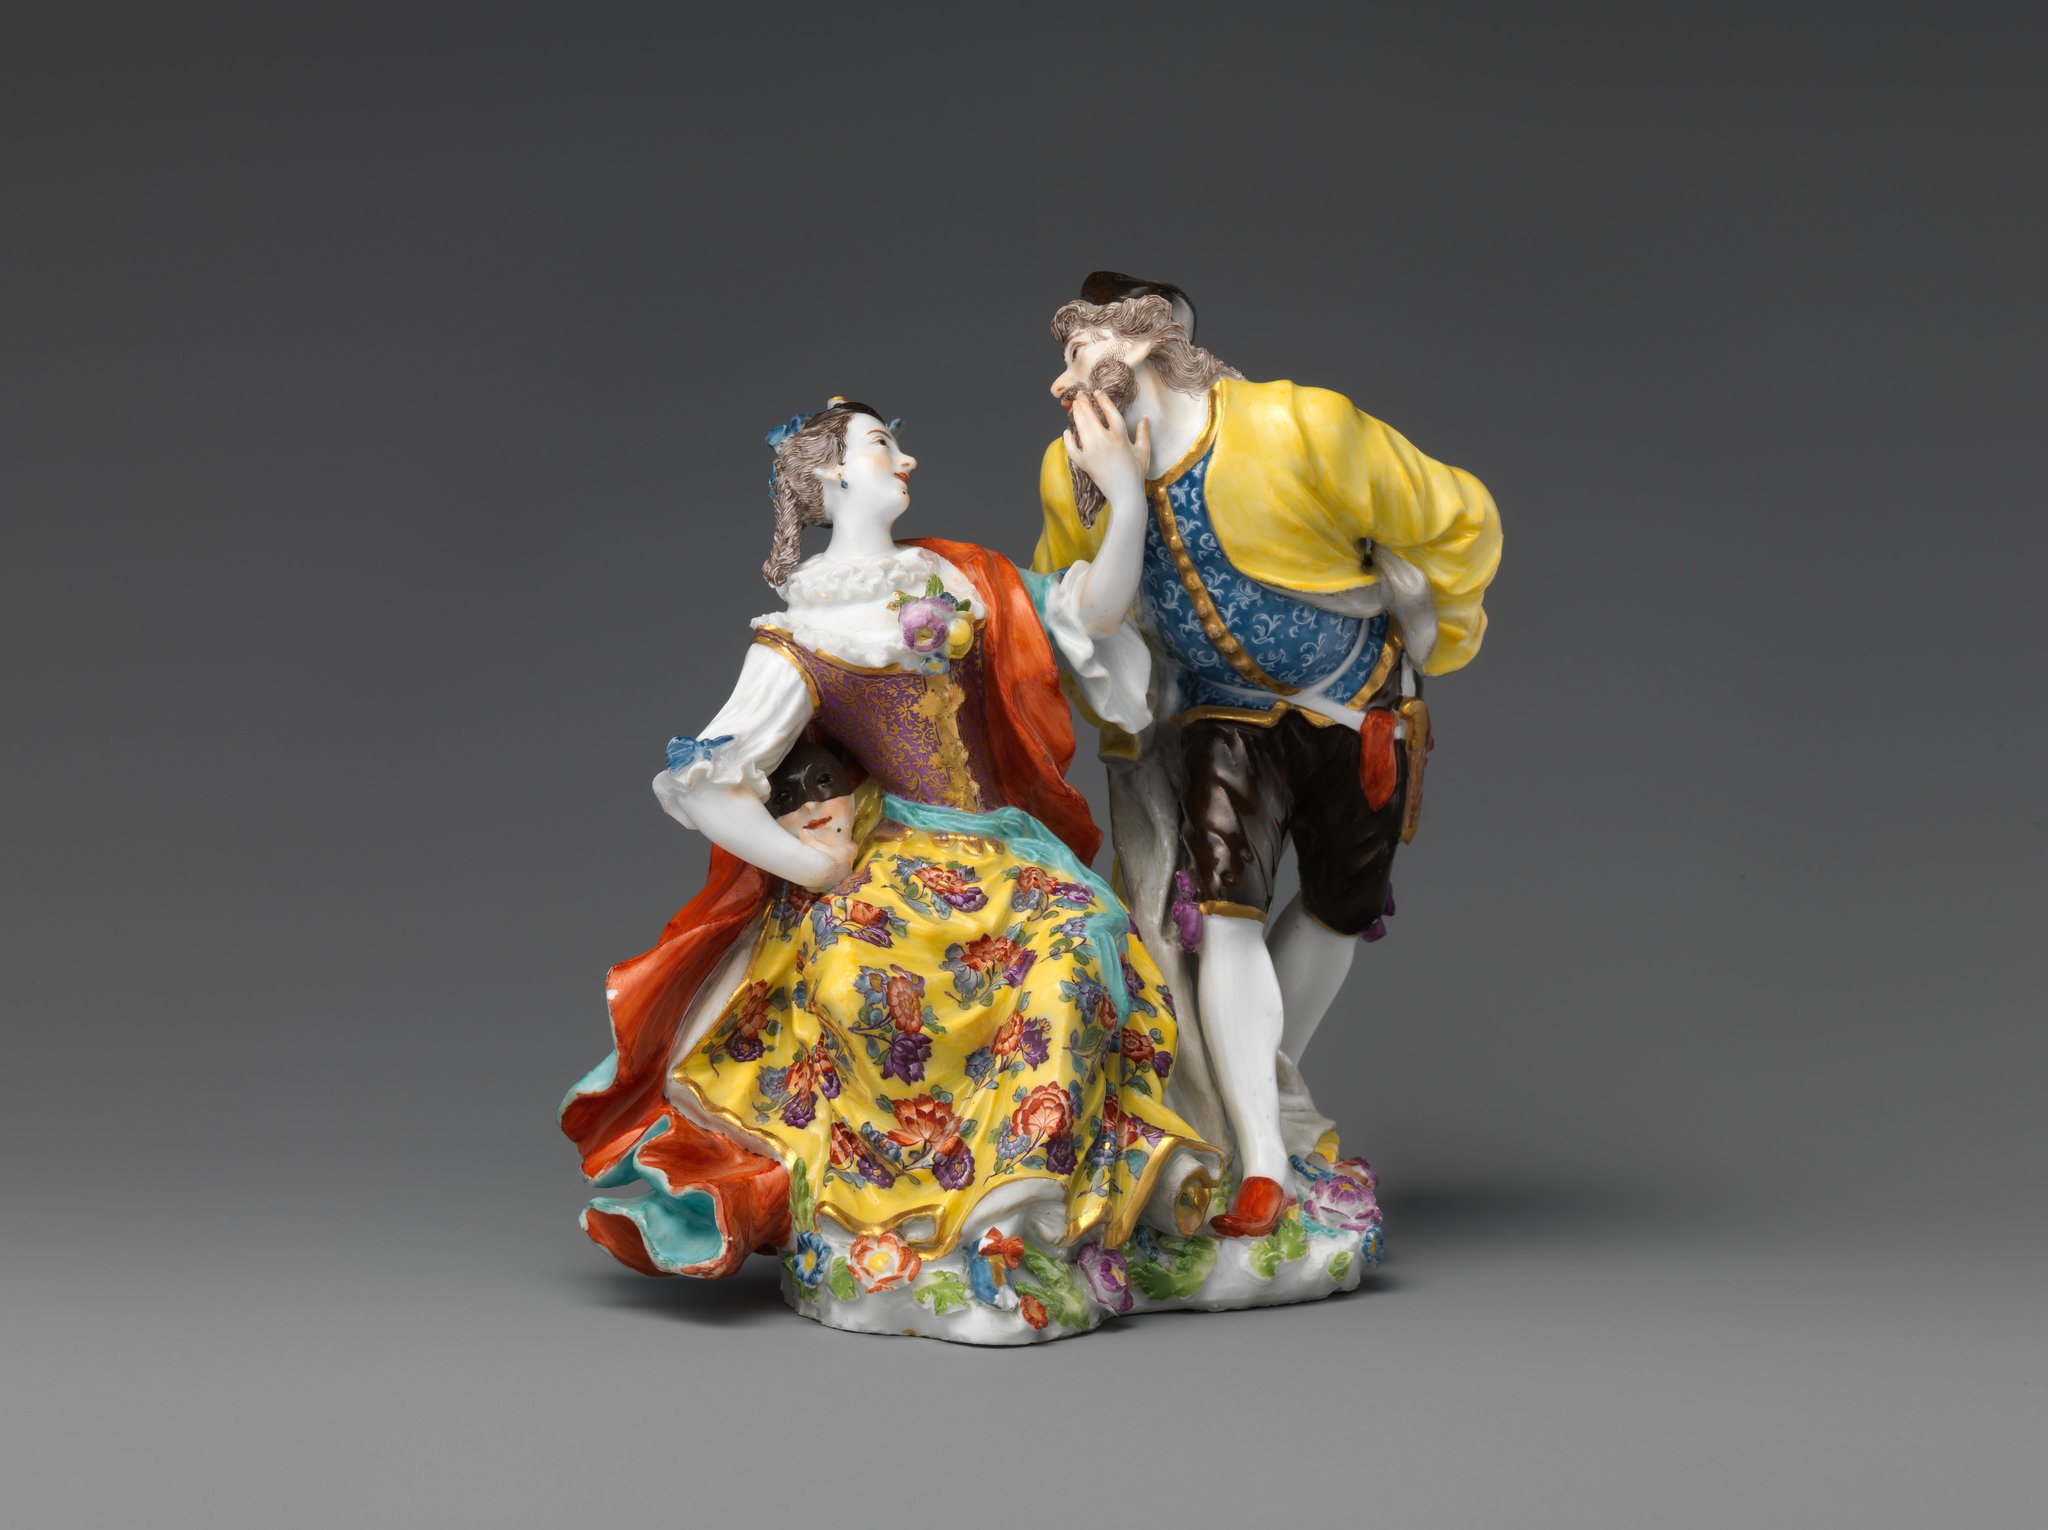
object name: group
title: Columbine and Pantaloon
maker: meissen manufactory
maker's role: manufactory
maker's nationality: german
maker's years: 1710-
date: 1738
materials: hard paste porcelain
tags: men,women